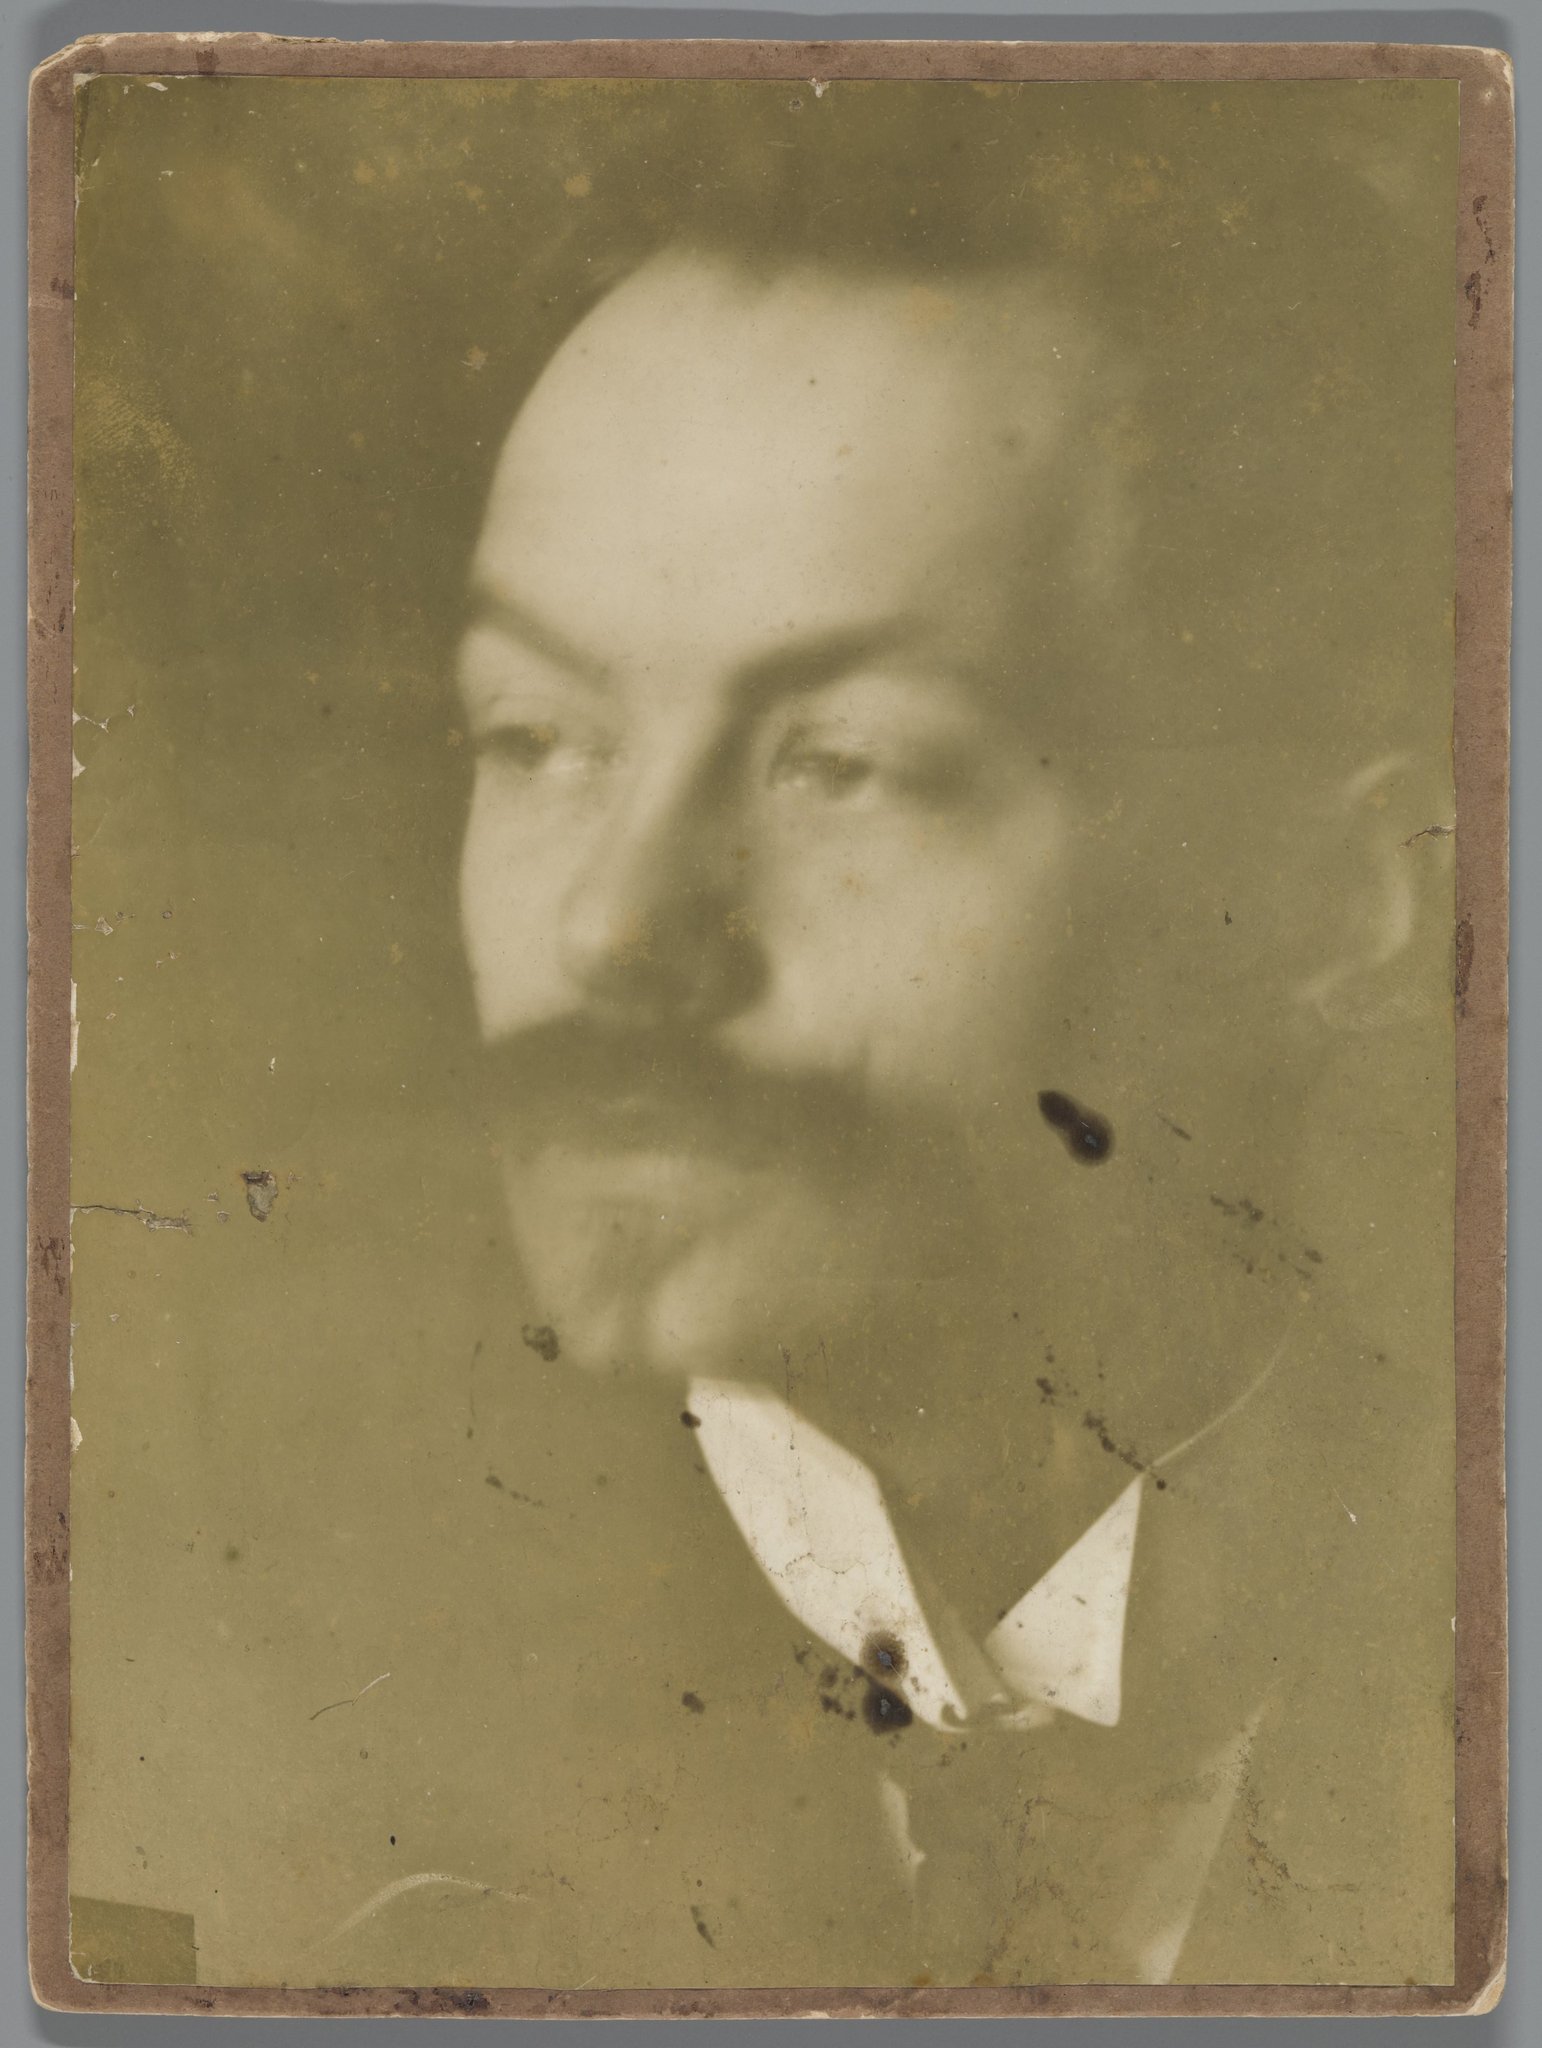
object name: photograph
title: Diepenbrock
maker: willem witsen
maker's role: draughtsman, painter, print maker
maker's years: 1860-1923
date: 1893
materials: cardboard, paper, photographic support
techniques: gelatin silver print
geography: amsterdam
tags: alphons diepenbrock